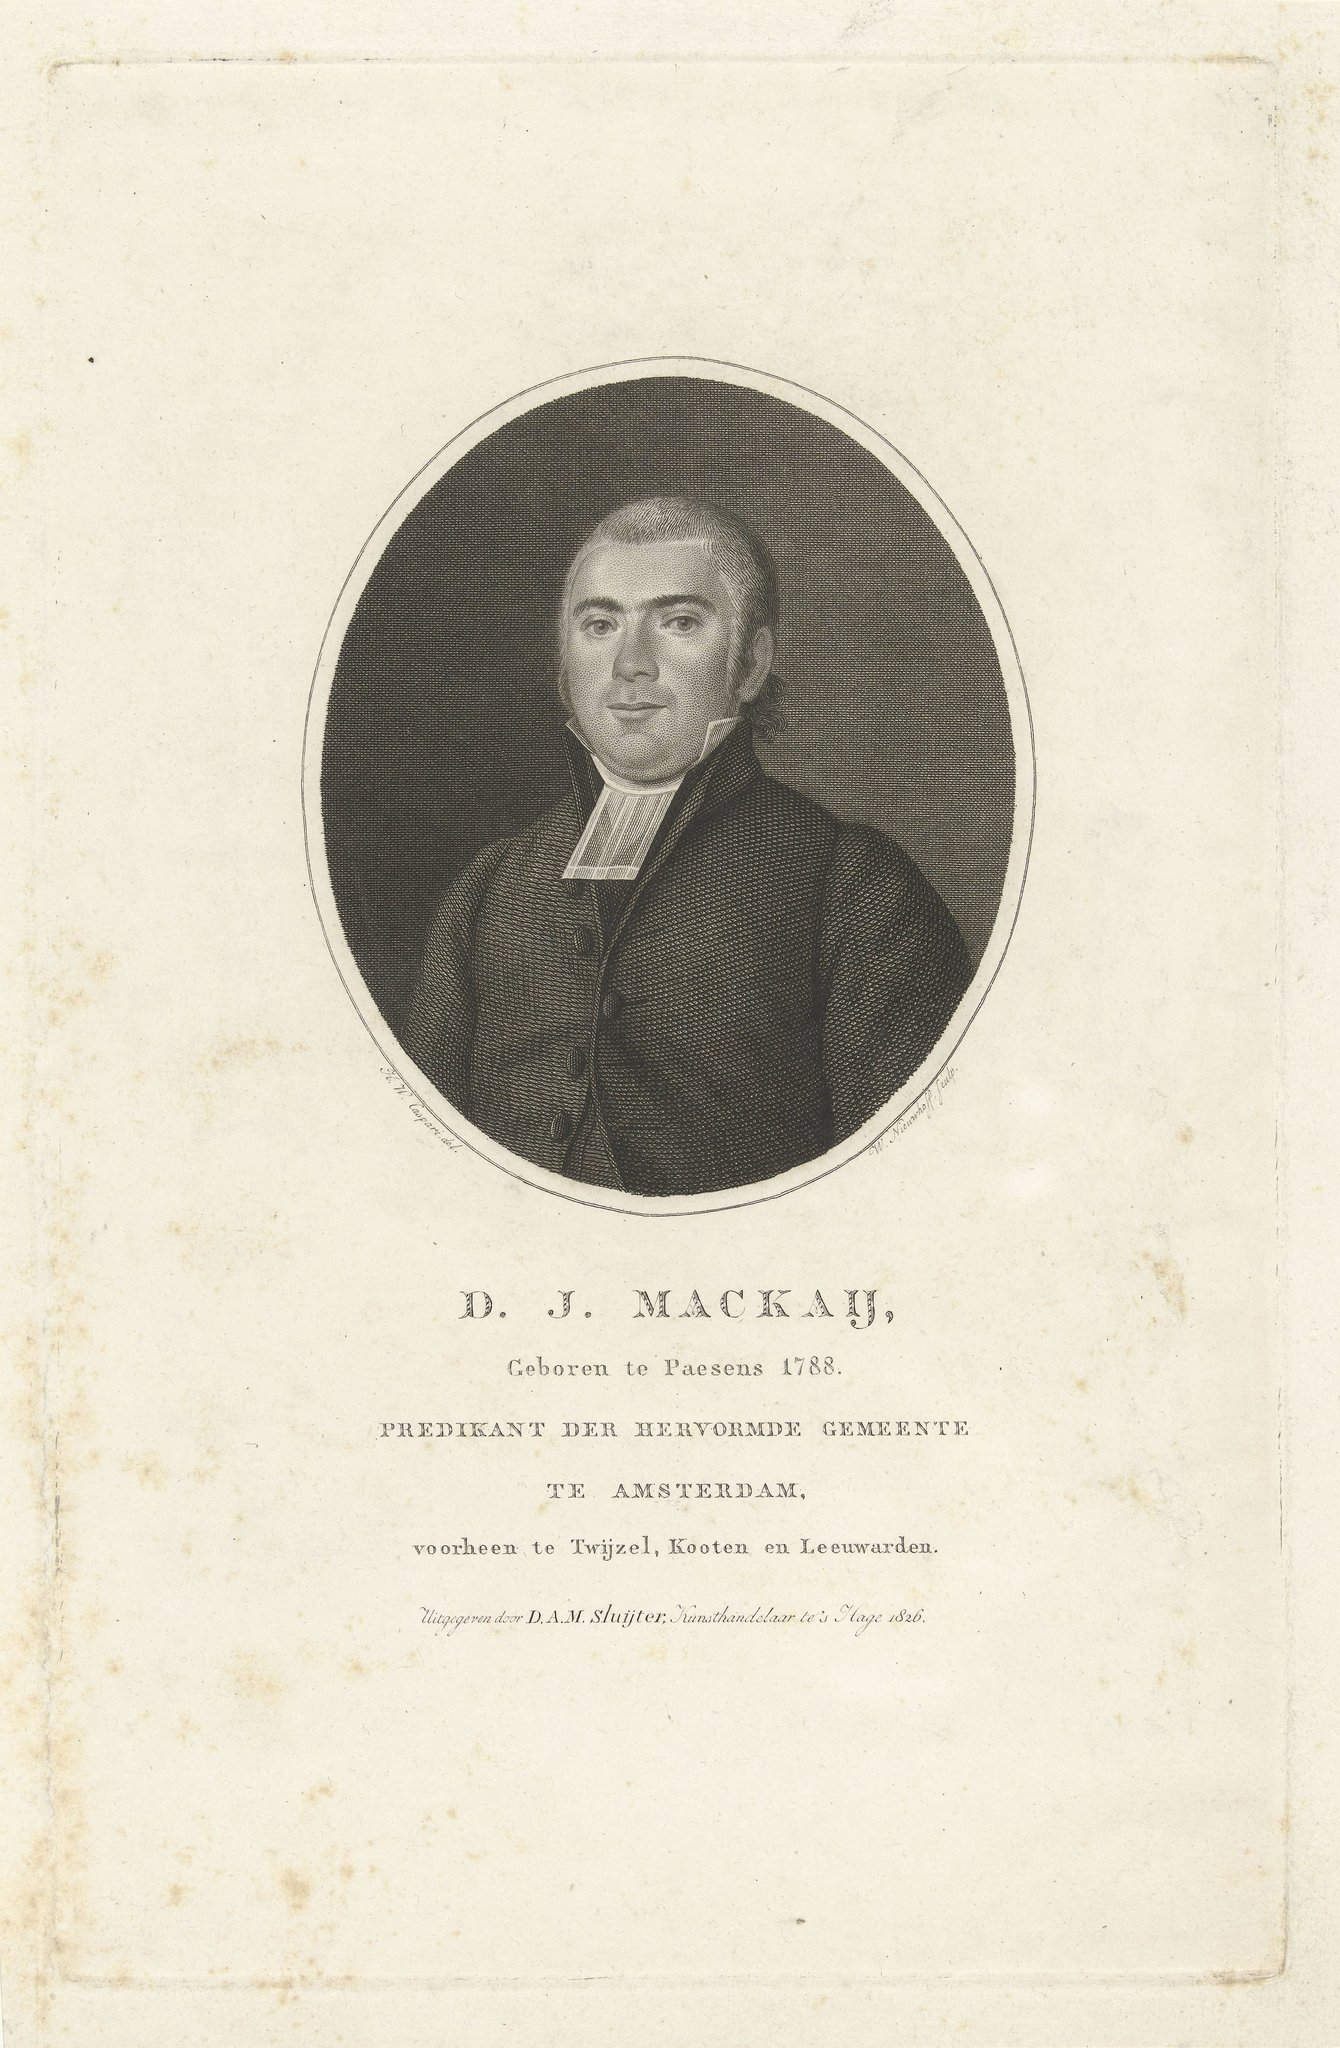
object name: print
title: Portret van Daniël Johannes Mackay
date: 1826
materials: paper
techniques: engraving, etching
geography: the hague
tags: predikant, daniël johannes mackay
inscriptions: collector's mark: Lugt 2228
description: Portret van Daniël Johannes Mackay, Hervormd predikant te Amsterdam, gekleed in zwarte jas met een witte bef. Buste naar links in ovaal. Onderaan in de marge een vierregelige tekst in het Nederlands.